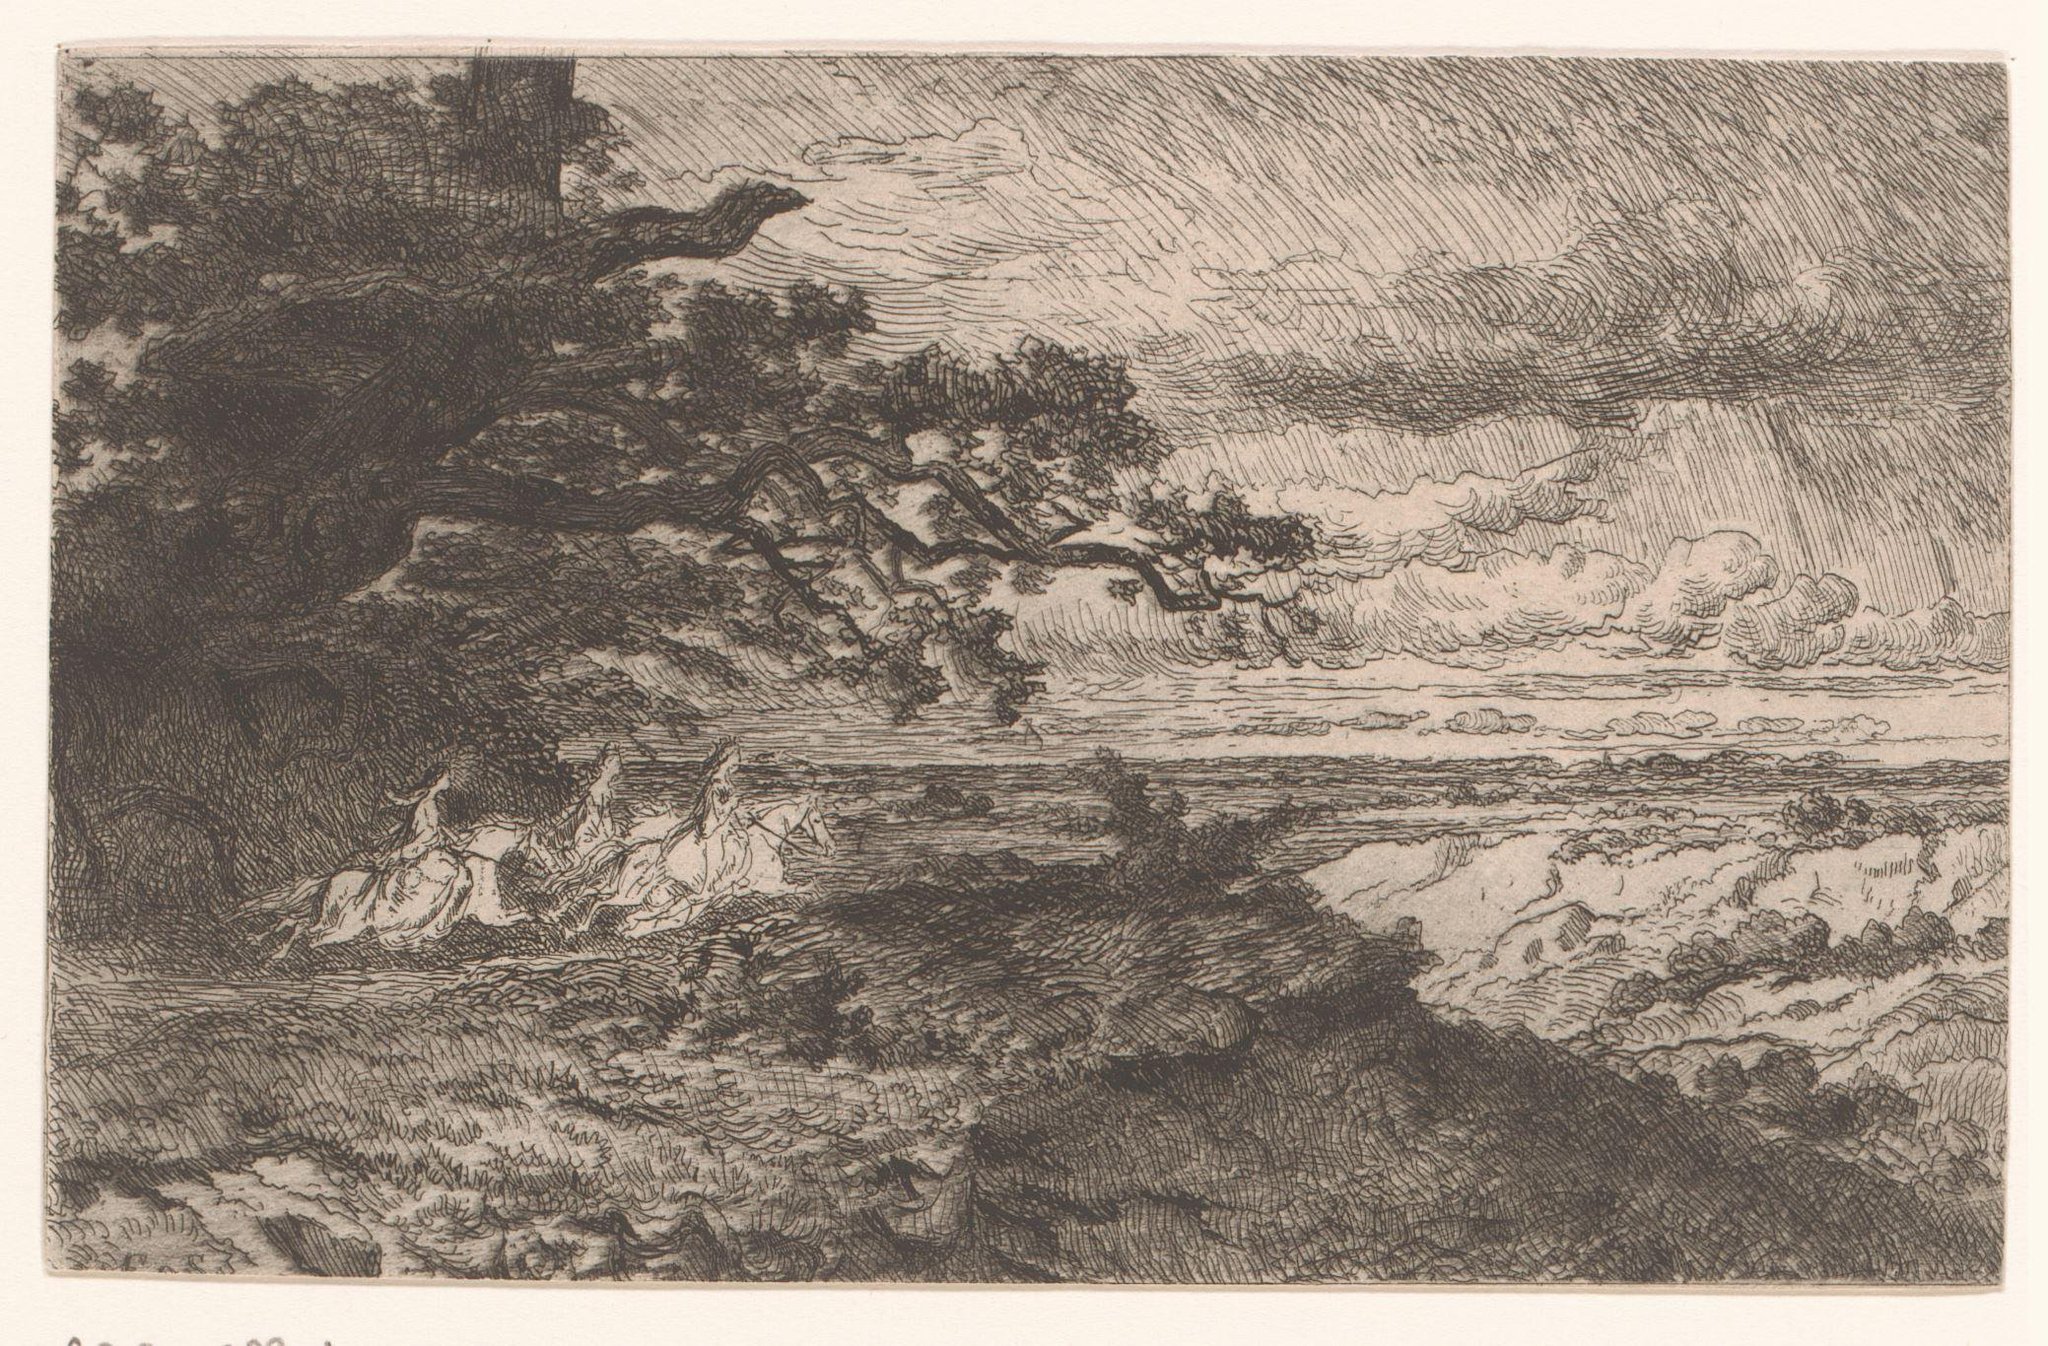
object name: print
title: Drie amazones te paard in een heuvellandschap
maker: edmond de schampheleer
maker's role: print maker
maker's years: 1824-1899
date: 1857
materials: paper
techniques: etching, intaglio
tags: low hill country, (story of) the amazons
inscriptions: collector's mark: Lugt 2228